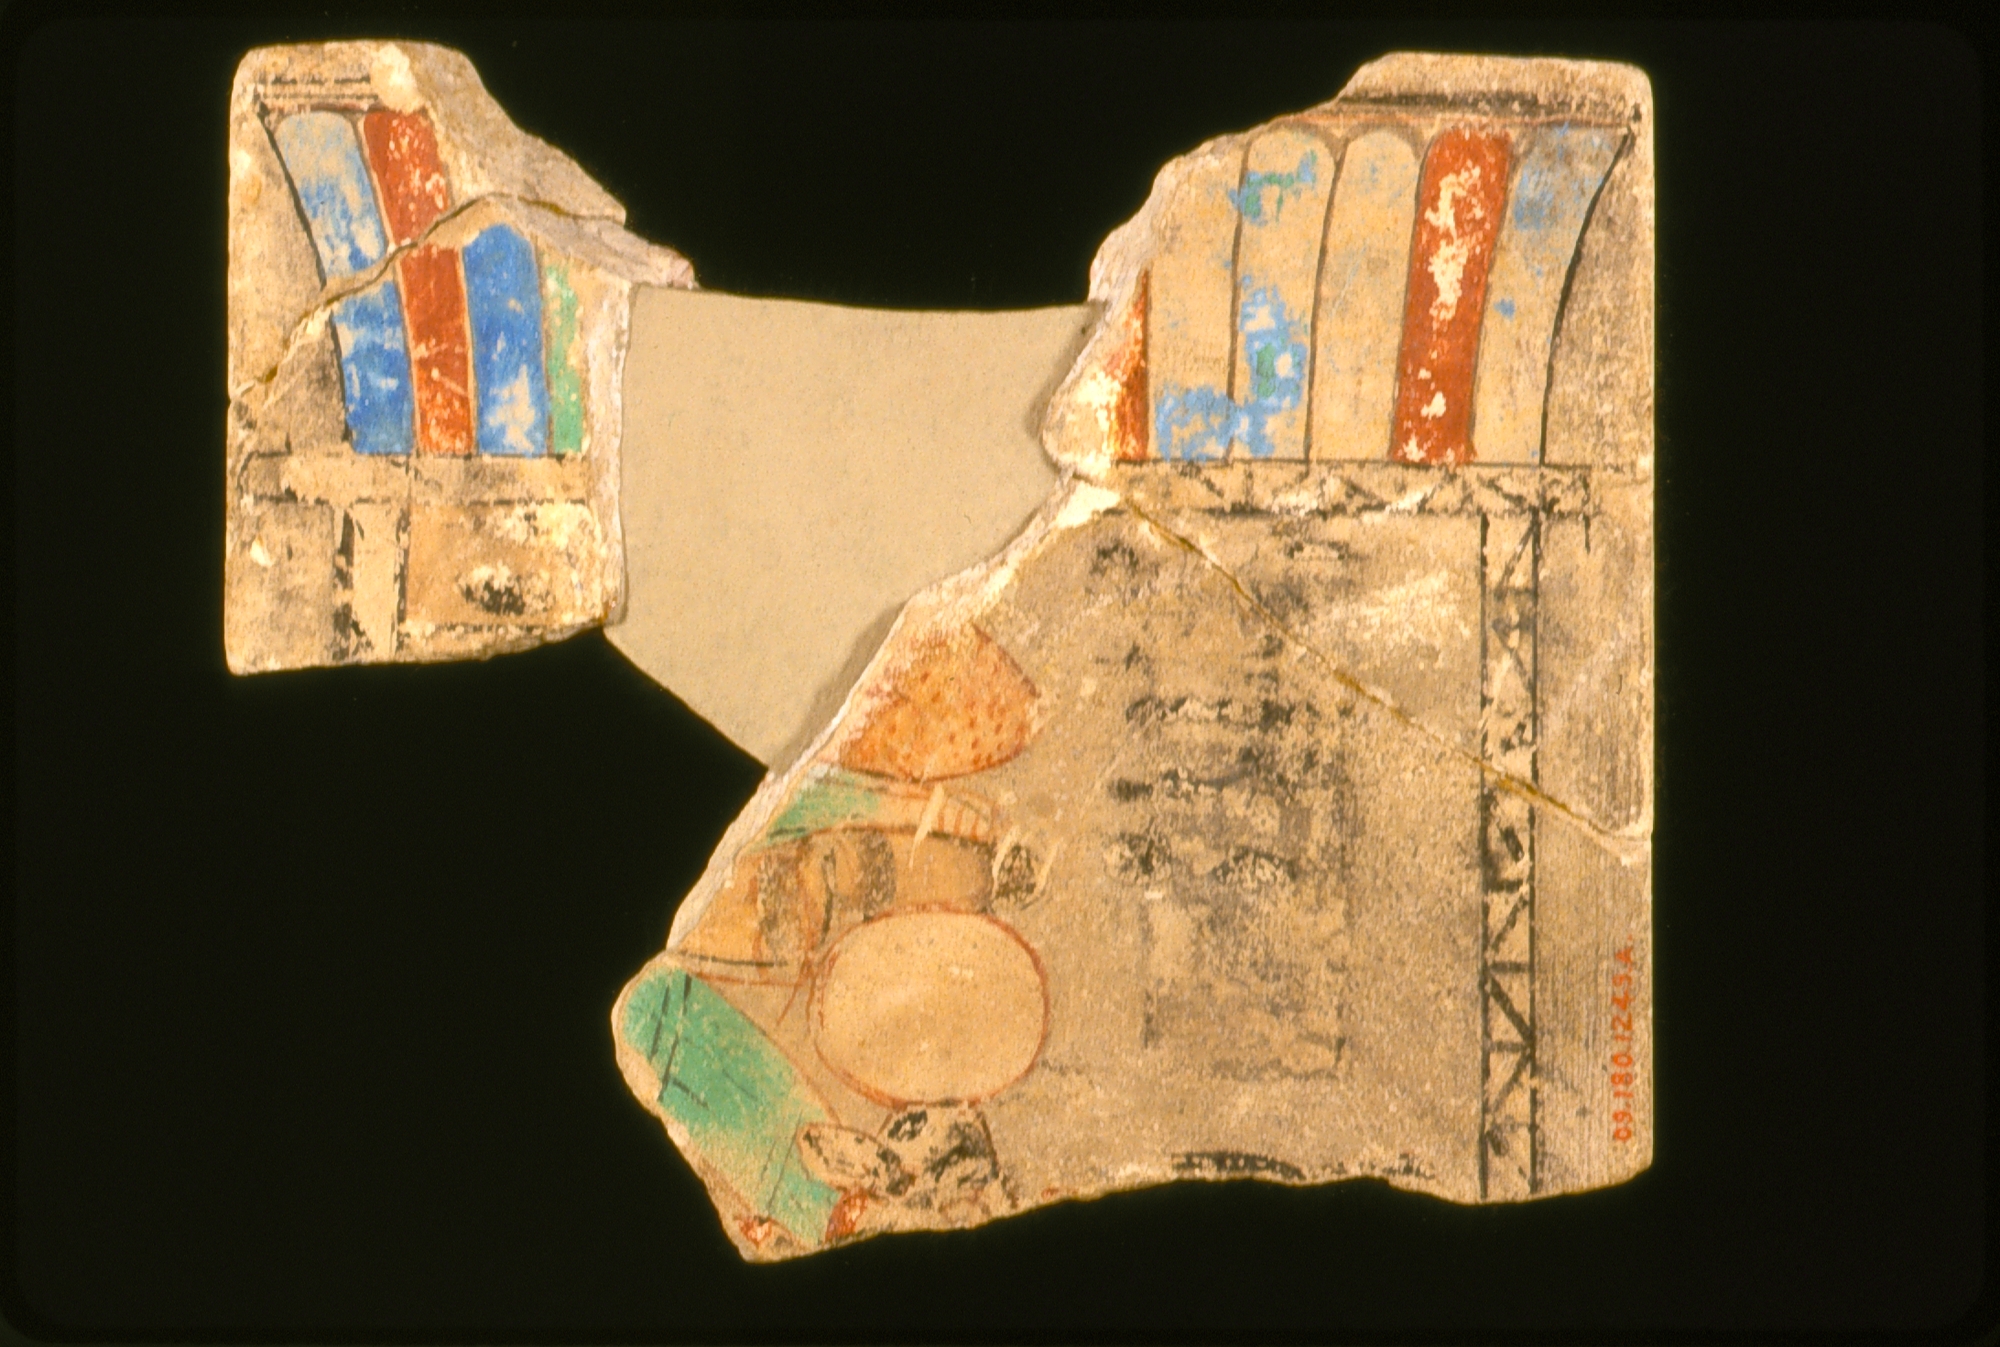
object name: stela fragment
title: Stela fragments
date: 1981-1802 BCE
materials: limestone, paint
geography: egypt